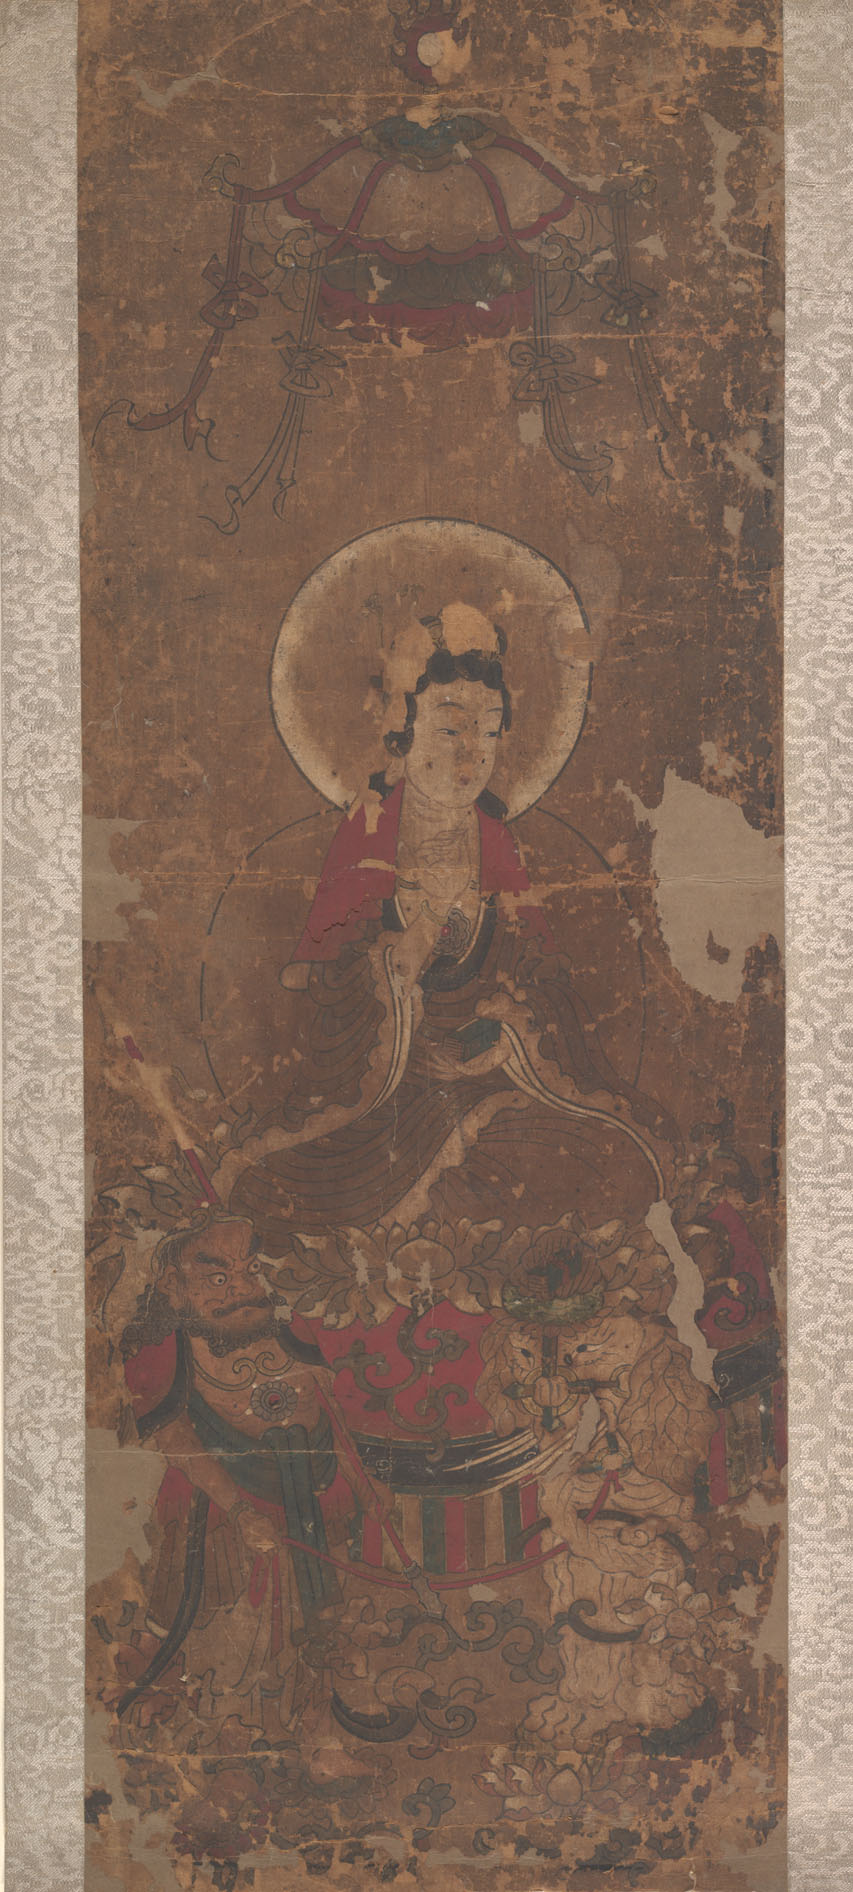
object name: hanging scroll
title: Pu Xian on Elephant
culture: chinese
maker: unidentified artist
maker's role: artist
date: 1368-1644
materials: ink, paper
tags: men